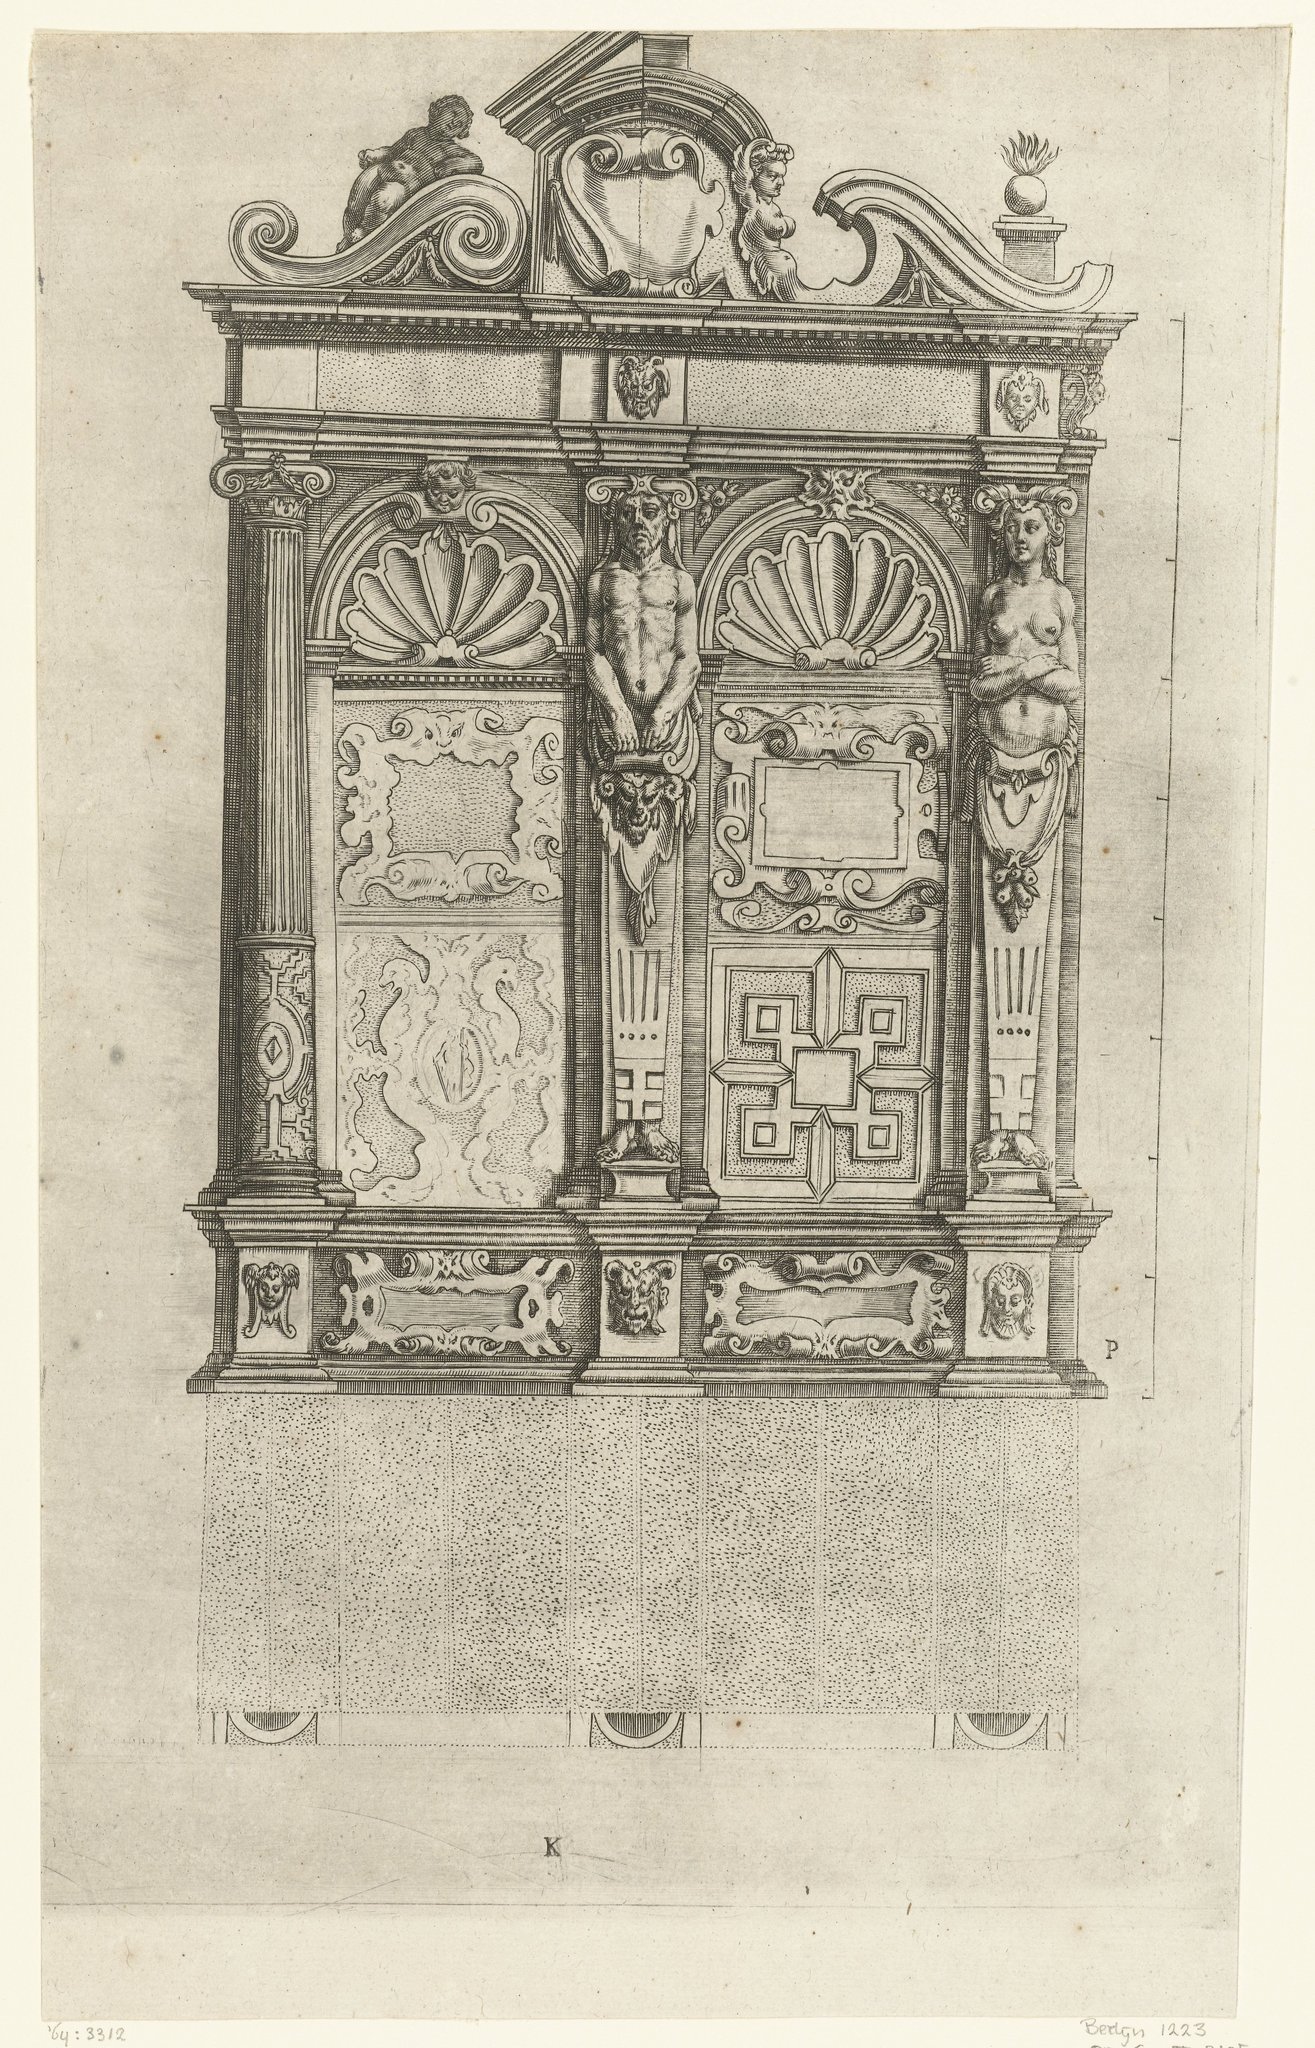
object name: print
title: Kabinet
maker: Anonymous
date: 1642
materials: paper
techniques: engraving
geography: amsterdam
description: Met variant voor de decoratie van de rechterhelft. De kast heeft drie pilaren, links een Ionische zuil, in het midden een mannelijke herme en rechts een vrouwelijke herme. Onderaan is een plan van de kast te zien en rechts staan de afmetingen.